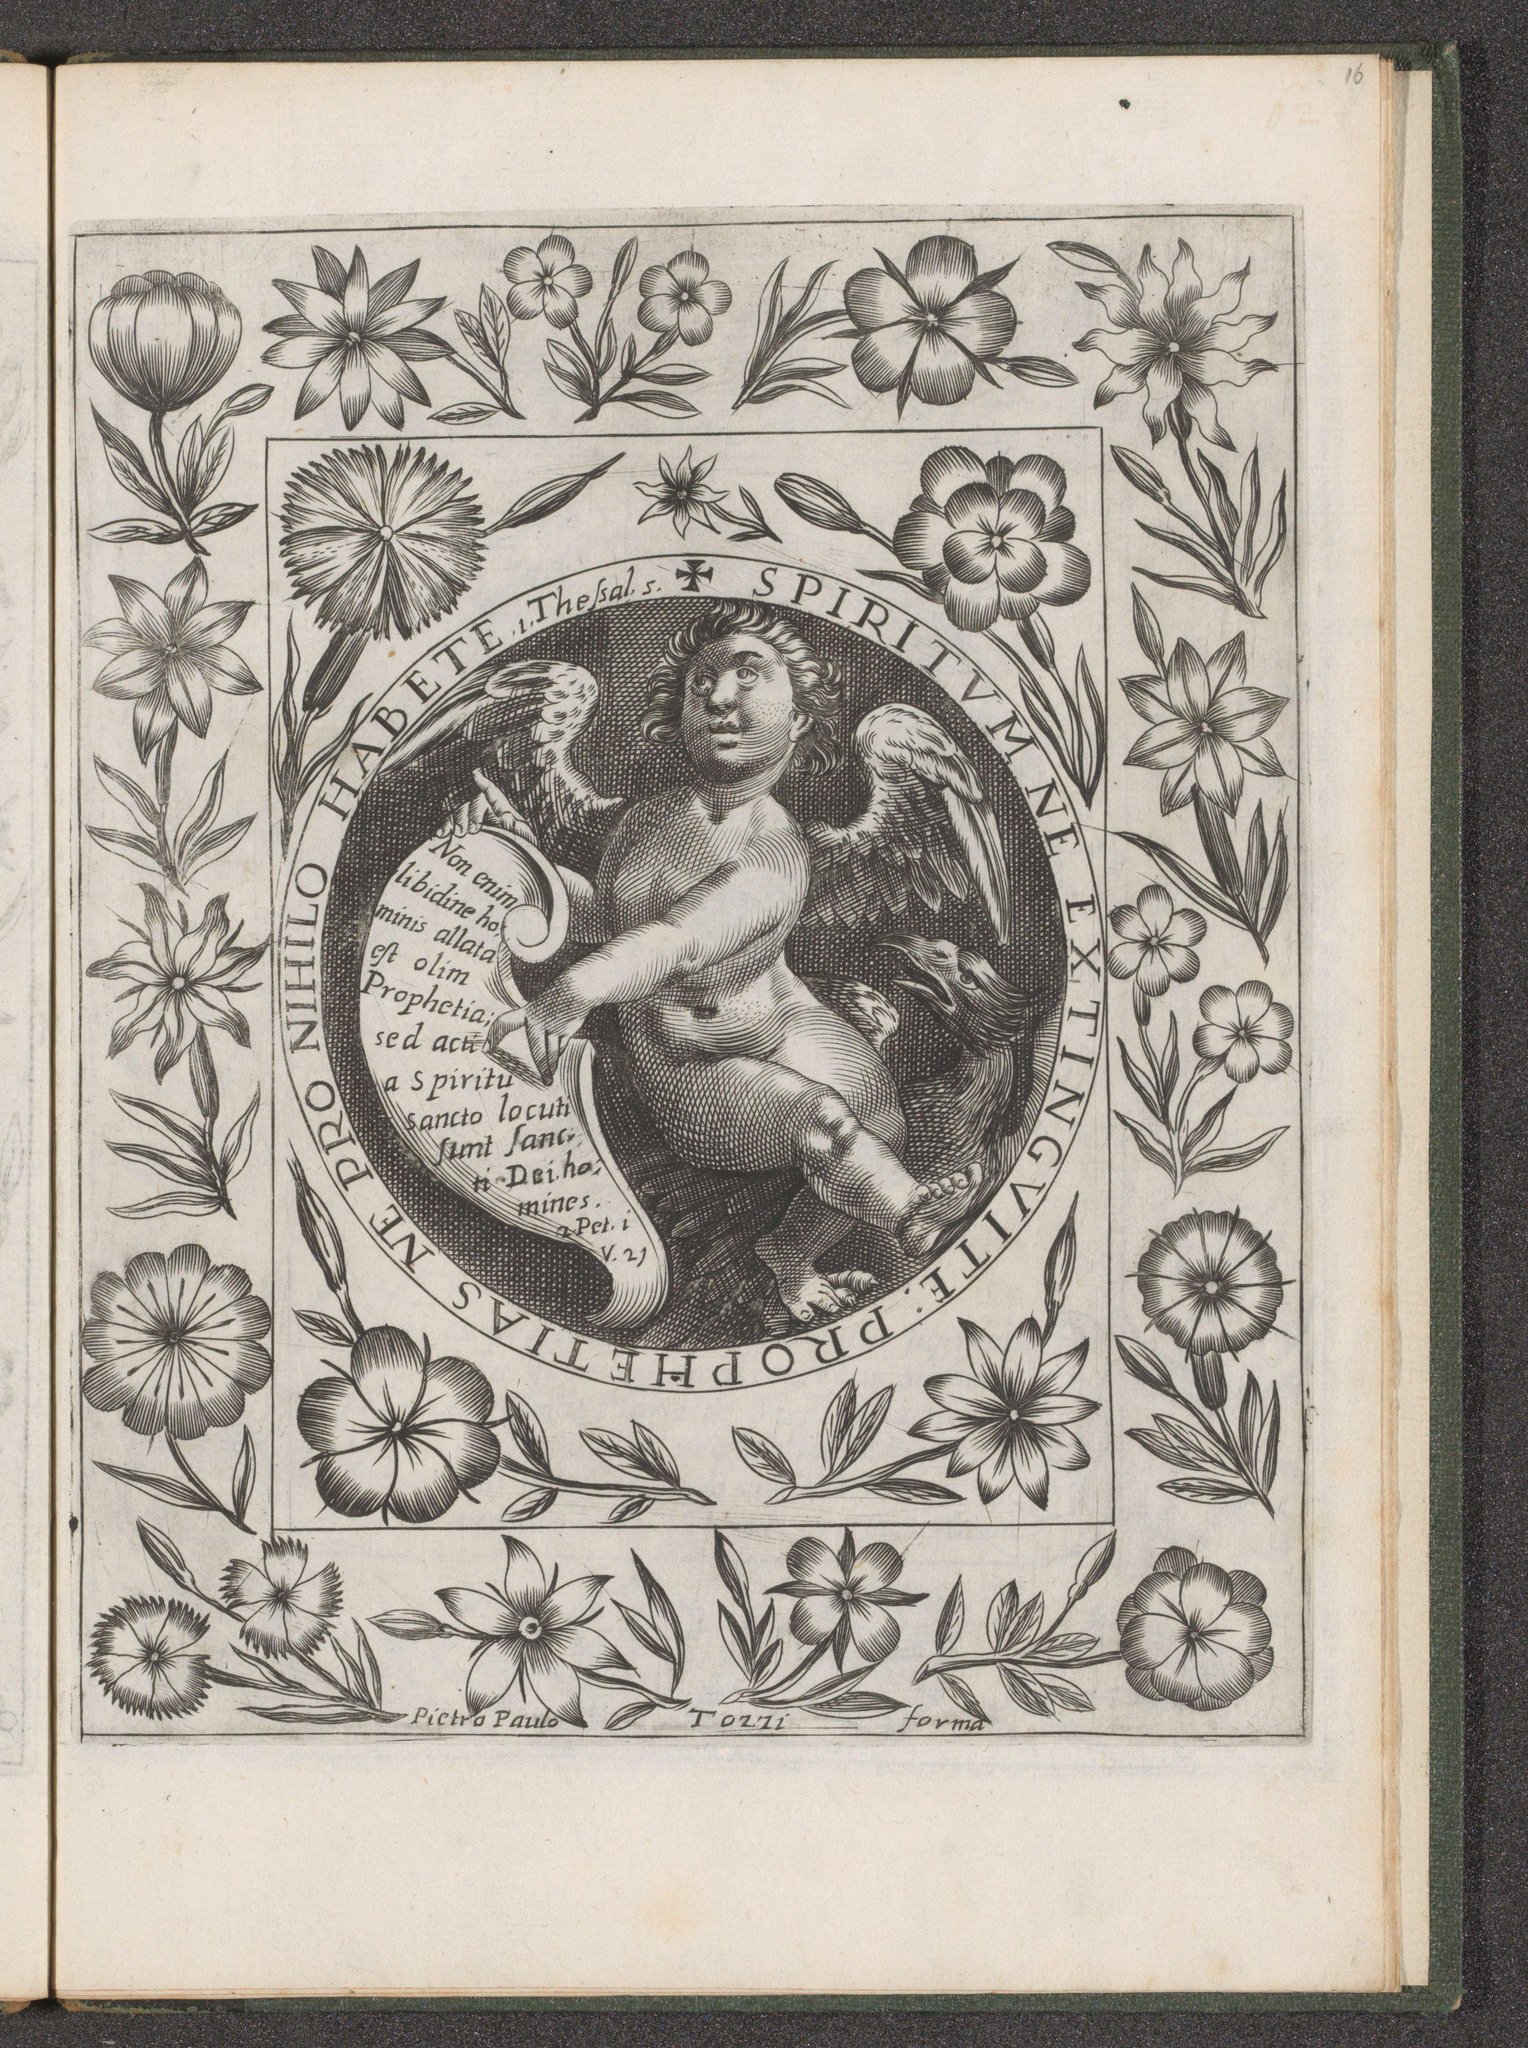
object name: album leaf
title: Imagini Gentilissime delle dodici Sibille (...)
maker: pietro paolo tozzi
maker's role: print maker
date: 1601-1627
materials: paper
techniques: engraving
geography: padua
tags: lamb bearing cross or banner, 'agnus dei' ~ symbol of christ, predatory birds: eagle, angel(s) with book(-scroll) or banderole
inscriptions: number: ‘62.’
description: Een engel die wijst op een banderol met een Bijbelcitaat in het Latijn uit 2 Petr. 1:21. Op de achtergrond een adelaar. De voorstelling is gevat in een medaillon met een randschrift met een tekst uit 1 Tess. 5:19-20 in het Latijn. Rondom een kader met bloemen. Prent maakt deel uit van een album.